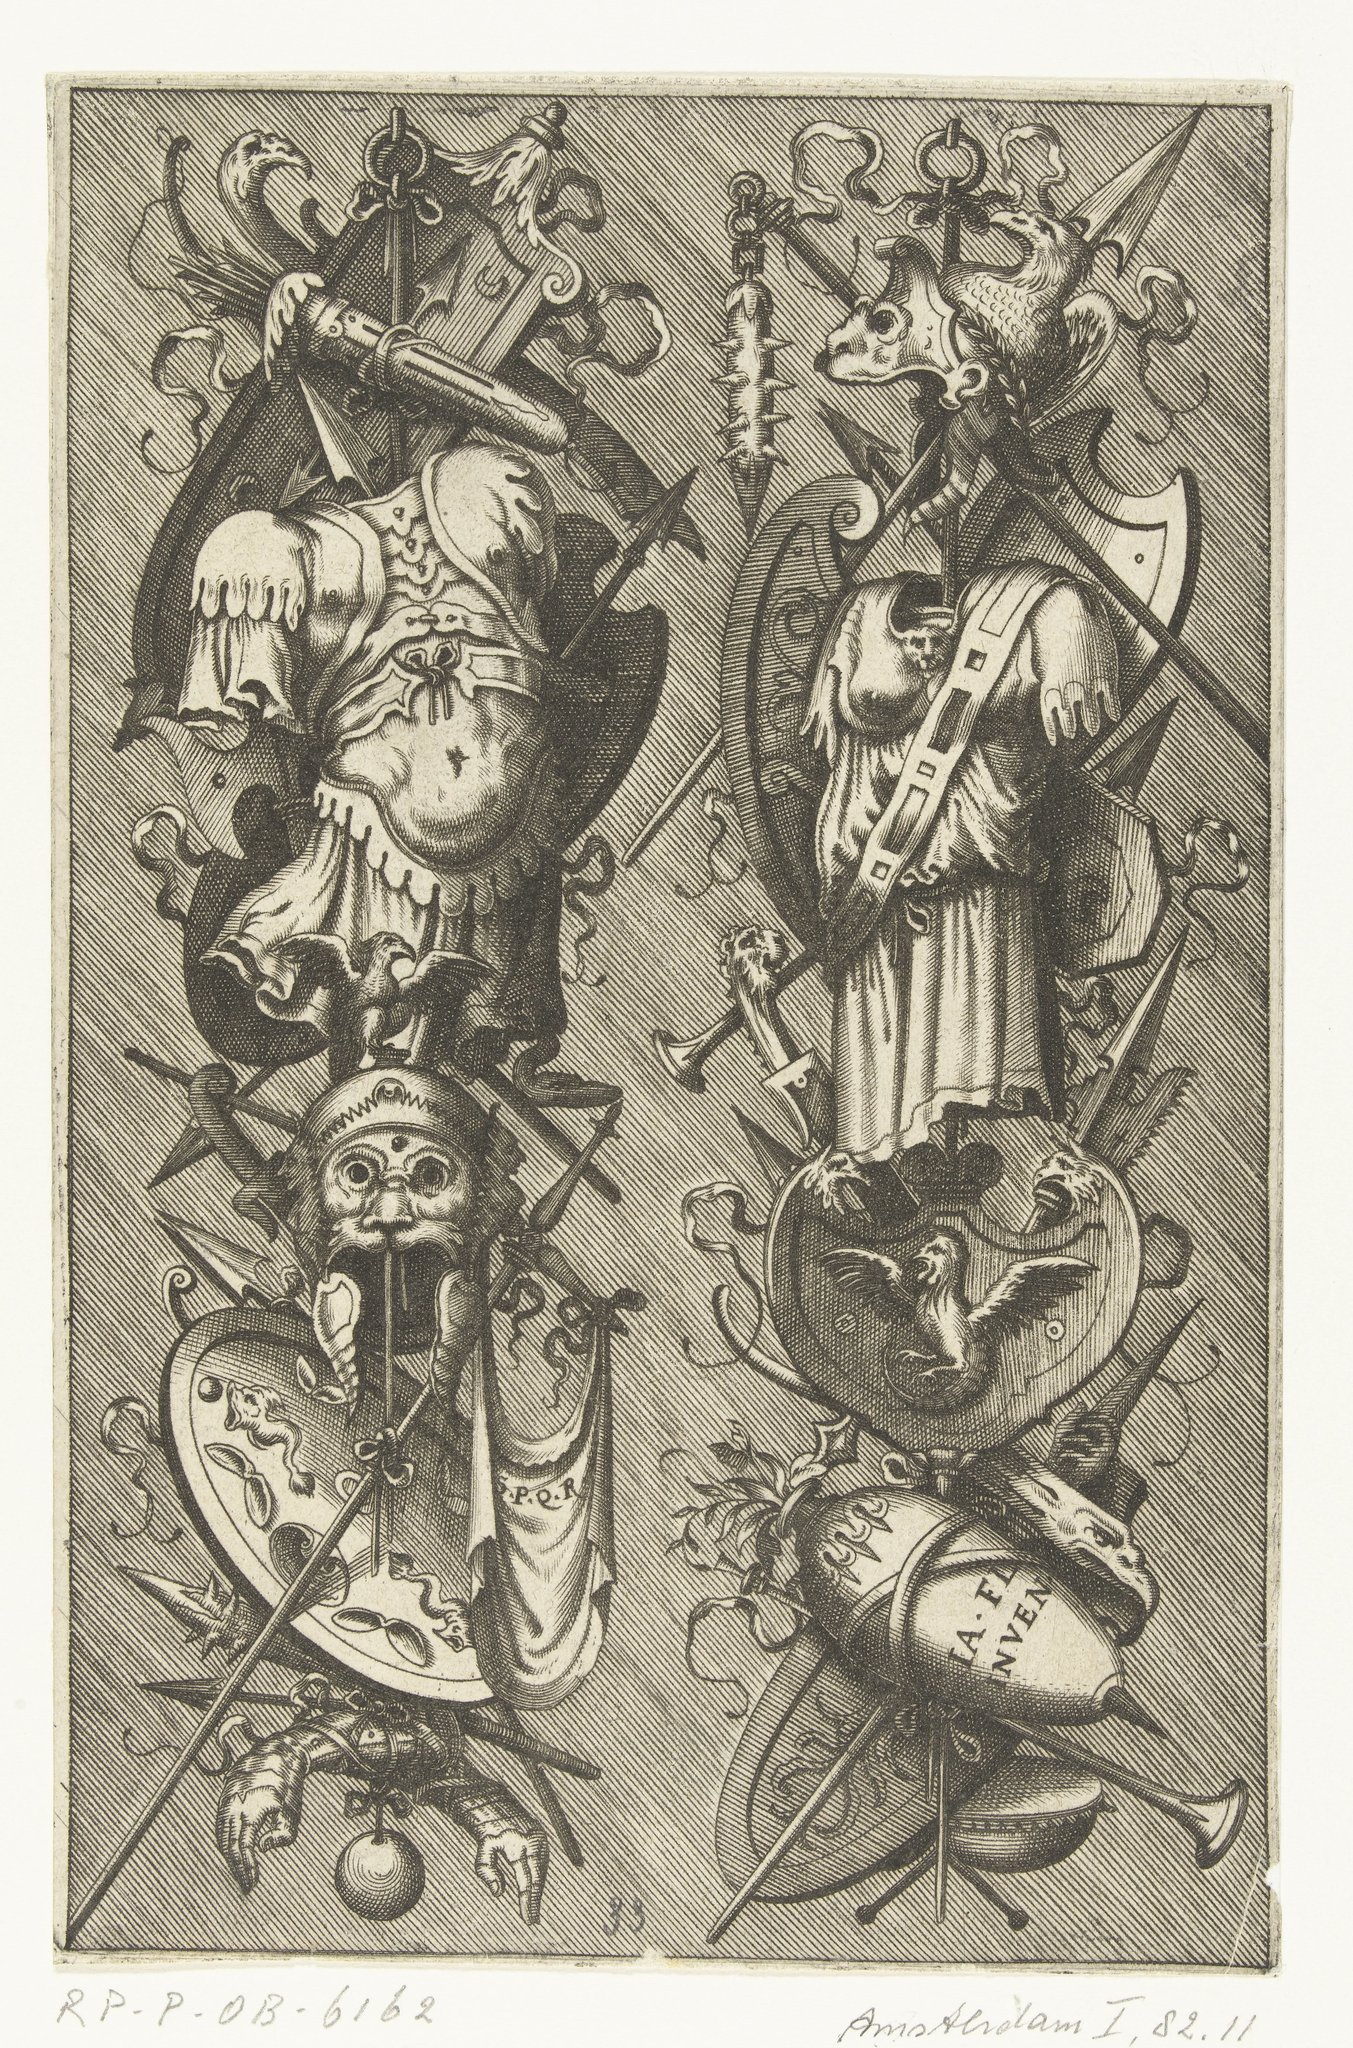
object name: print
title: Twee wapentrofeeën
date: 1567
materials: paper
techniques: engraving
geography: netherlands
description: De linker trofee bestaat ondermeer uit een schild, een kuras, een helm in de vorm van een masker en een rond schild. In de rechter trofee hangen onder andere een helm, een tuniek met borstplaten, en een schild. Gearceerde achtergrond. Hoort bij serie van 14 bladen cartouches met rolwerk, grotesken, trofeeën en friezen. Het titelblad ontbreekt.